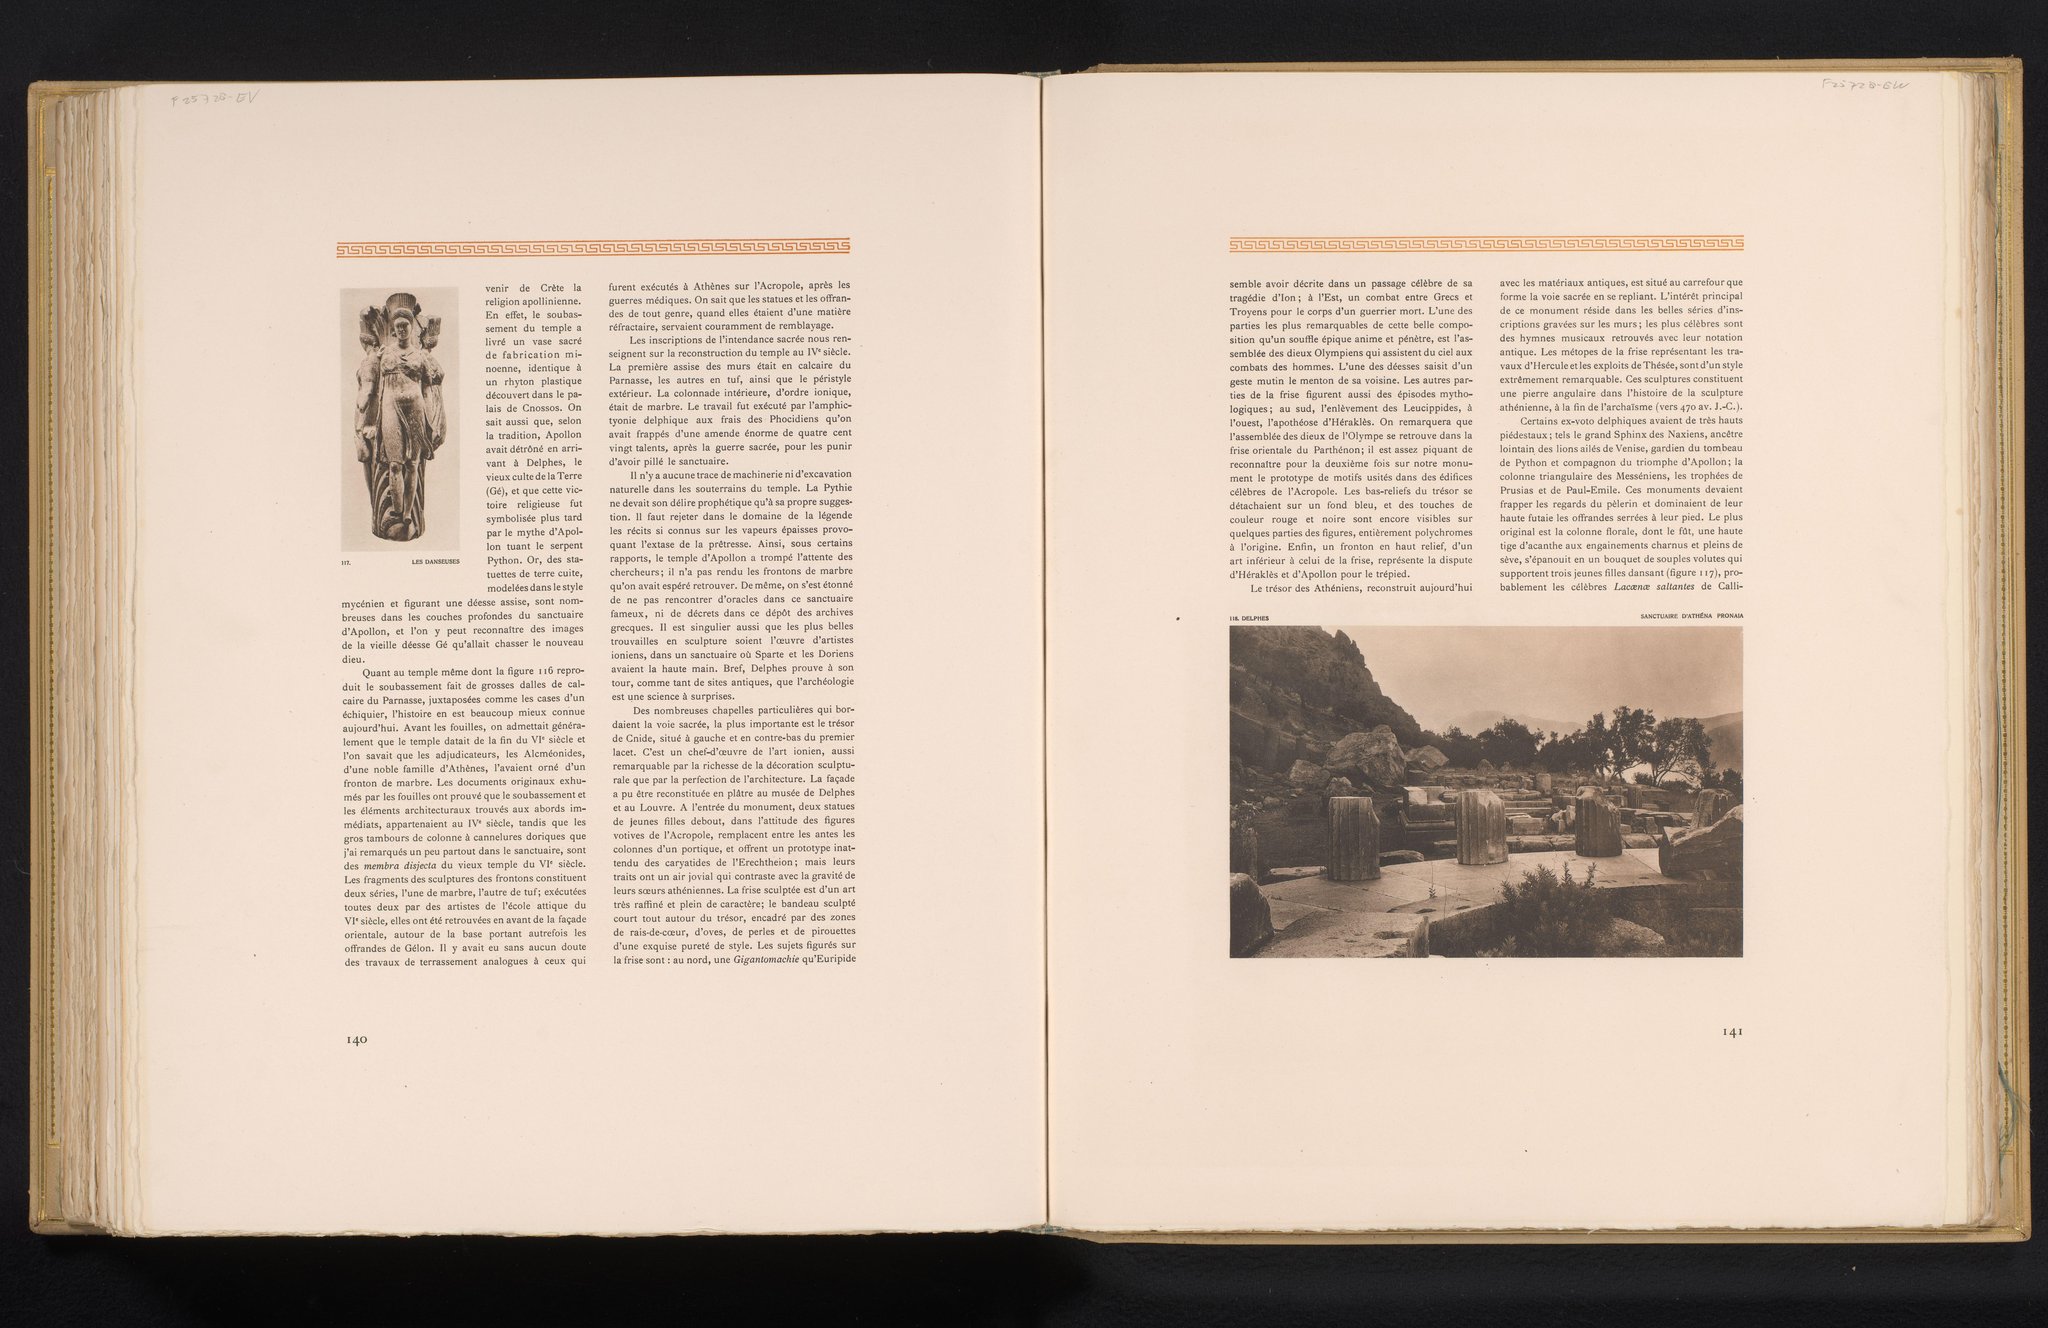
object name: page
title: Delphes, Sanctuaire d'Athéna Pronaia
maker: frédéric boissonnas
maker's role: fotograaf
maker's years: 1858-1946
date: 1905-1910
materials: paper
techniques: photograph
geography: delphi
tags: landscape with ruins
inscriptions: number: ‘118.’